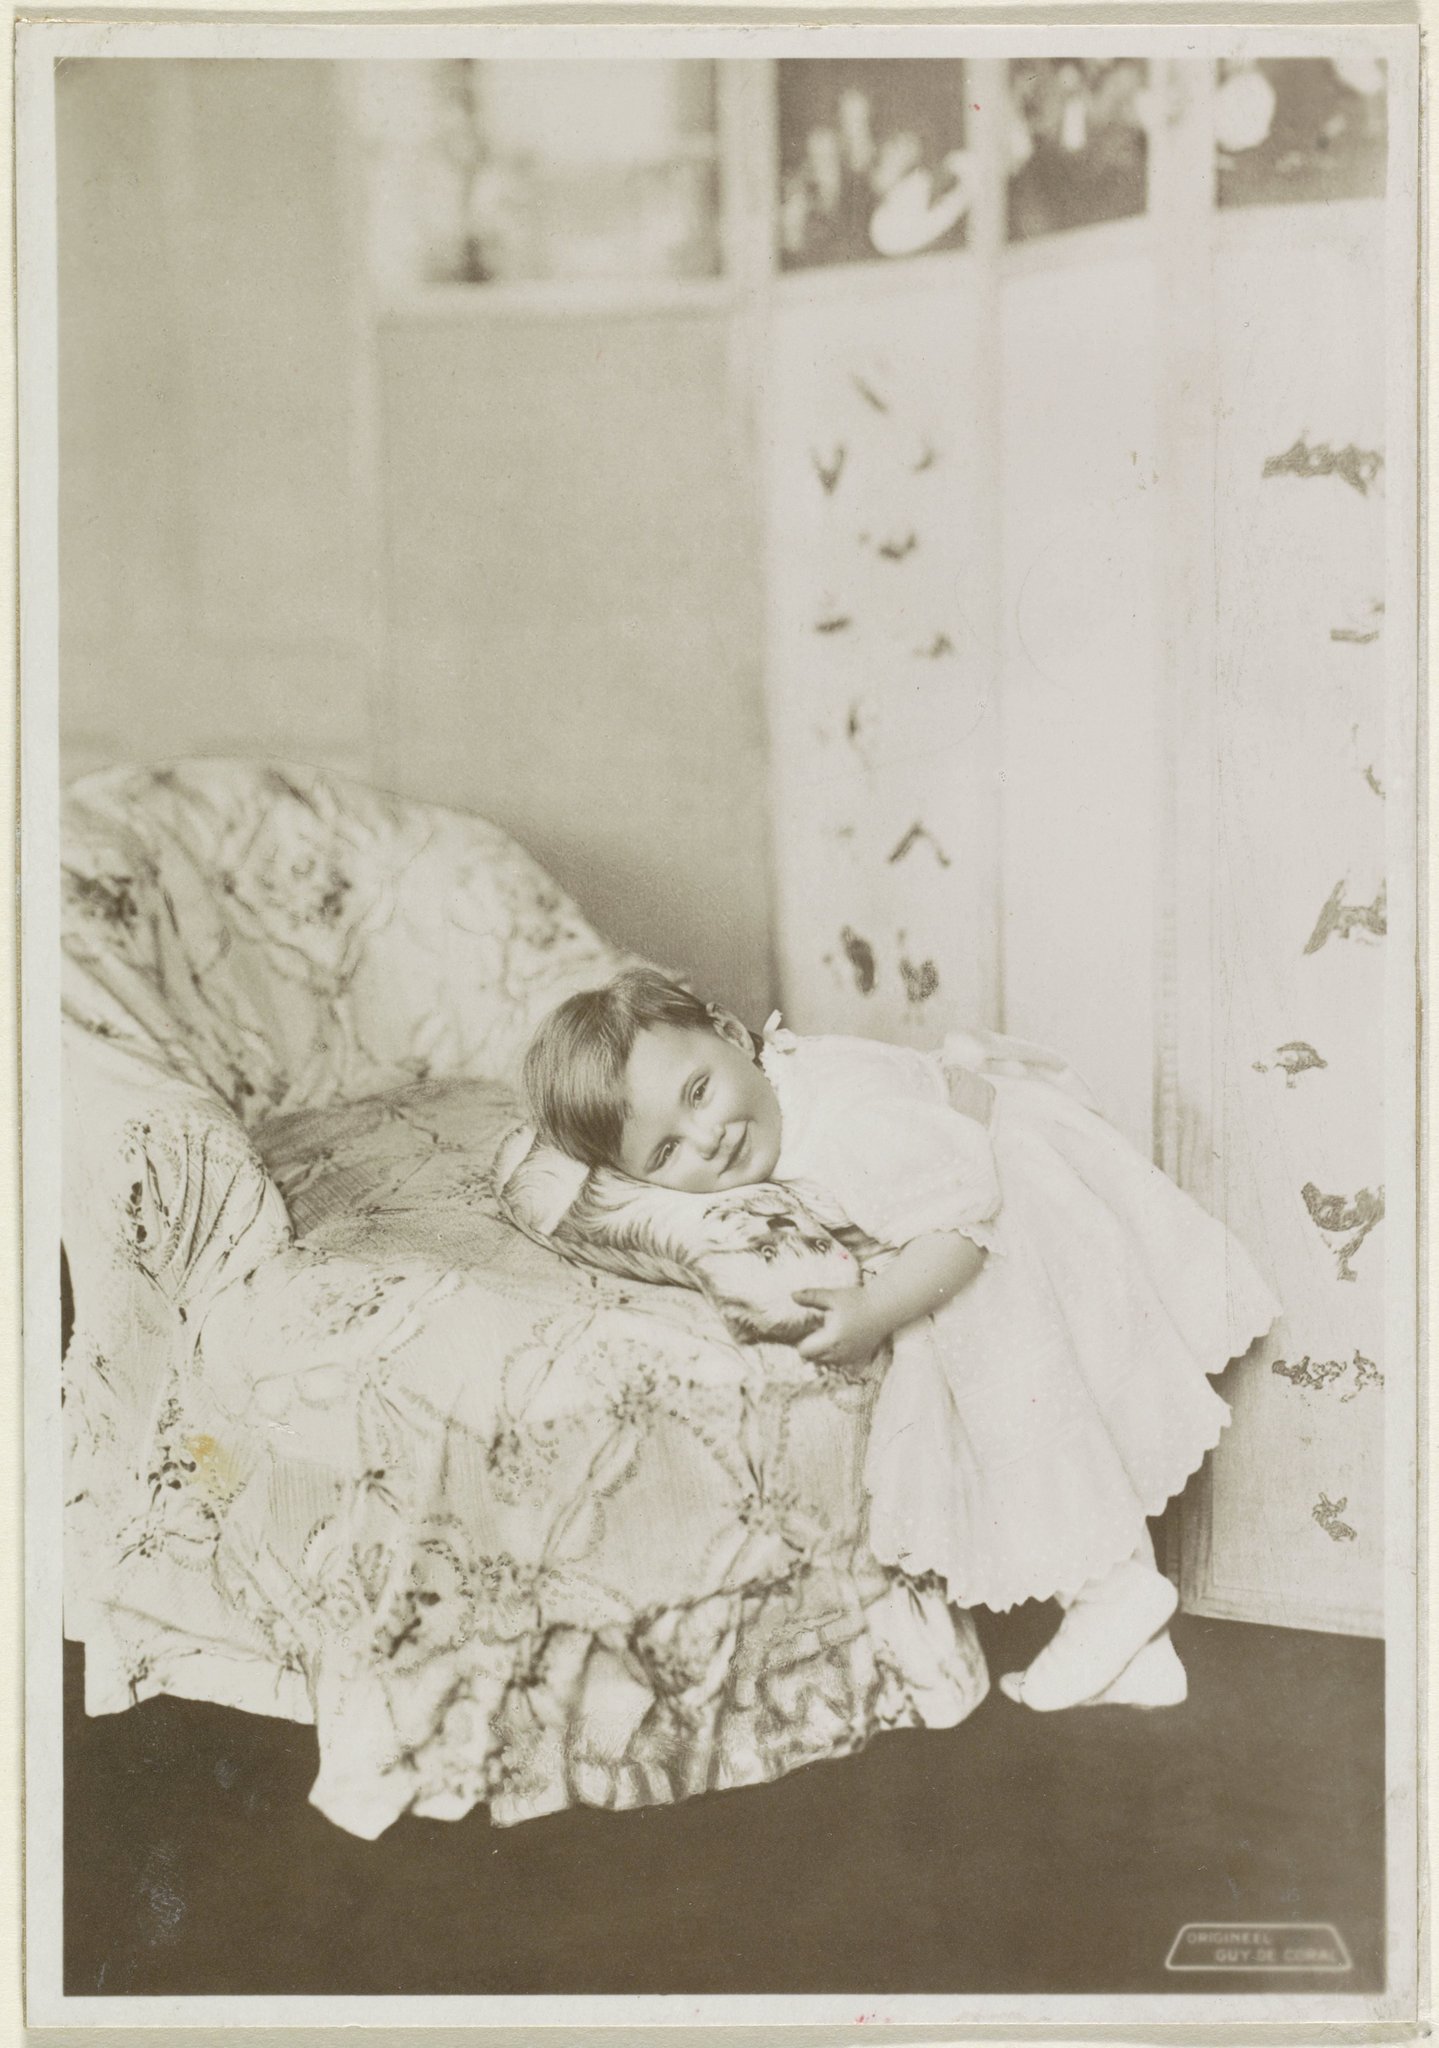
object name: photograph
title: Portret van Juliana, koningin der Nederlanden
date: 1911-1912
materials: photographic support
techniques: photography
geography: netherlands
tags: the hague, juliana of the netherlands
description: De hier vermelde titel verwijst naar de hoogst verkregen titel van de geportretteerde, niet per se naar de titel die de geportretteerde op deze voorstelling draagt.